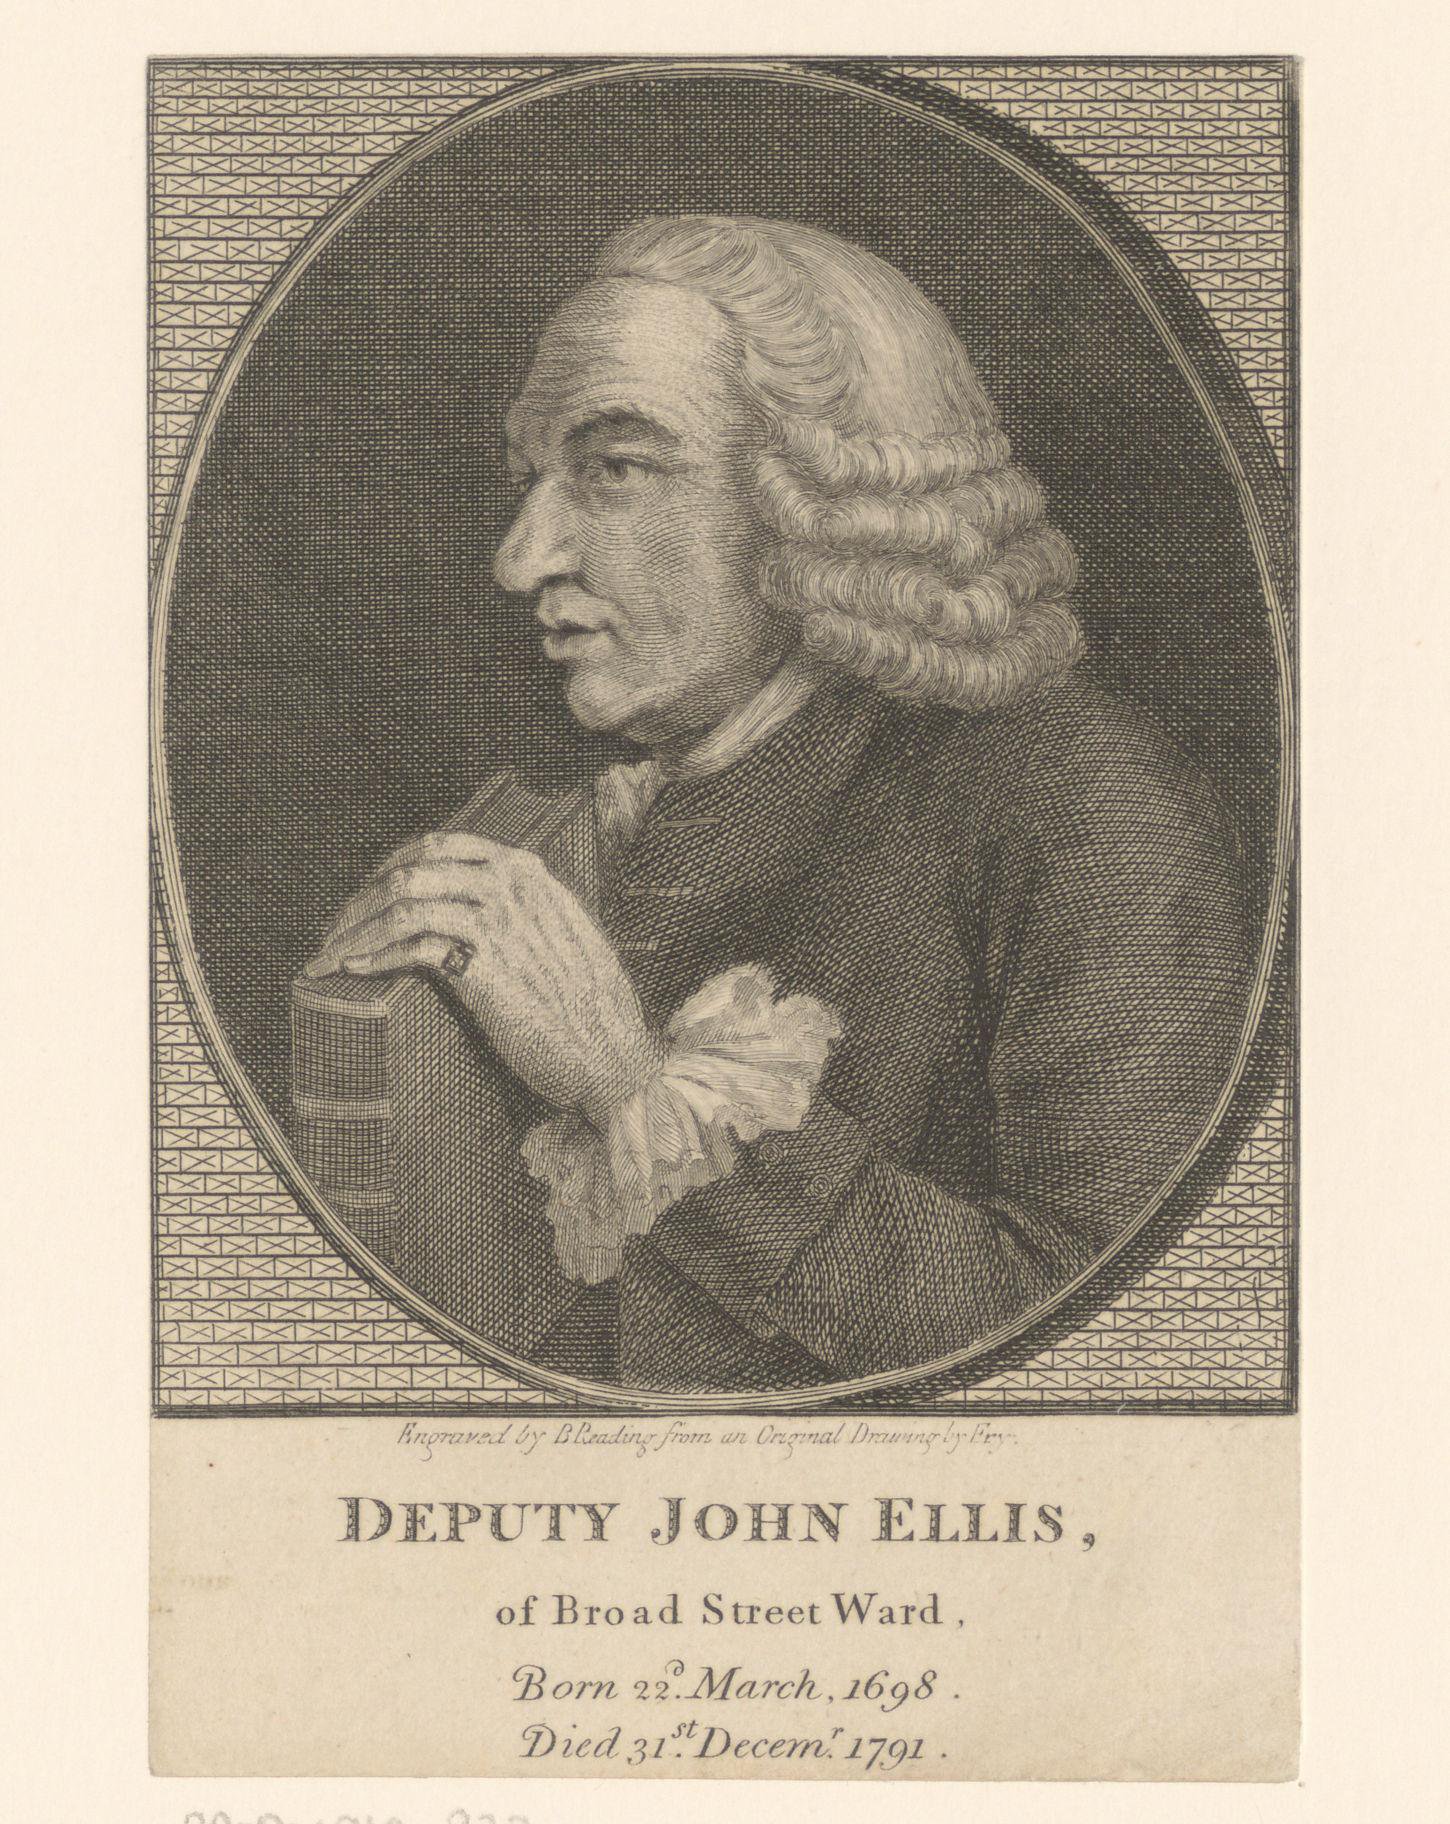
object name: print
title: Portret van John Ellis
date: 1759-1838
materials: paper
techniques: engraving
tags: john ellis, historical persons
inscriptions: collector's mark: Lugt 2228